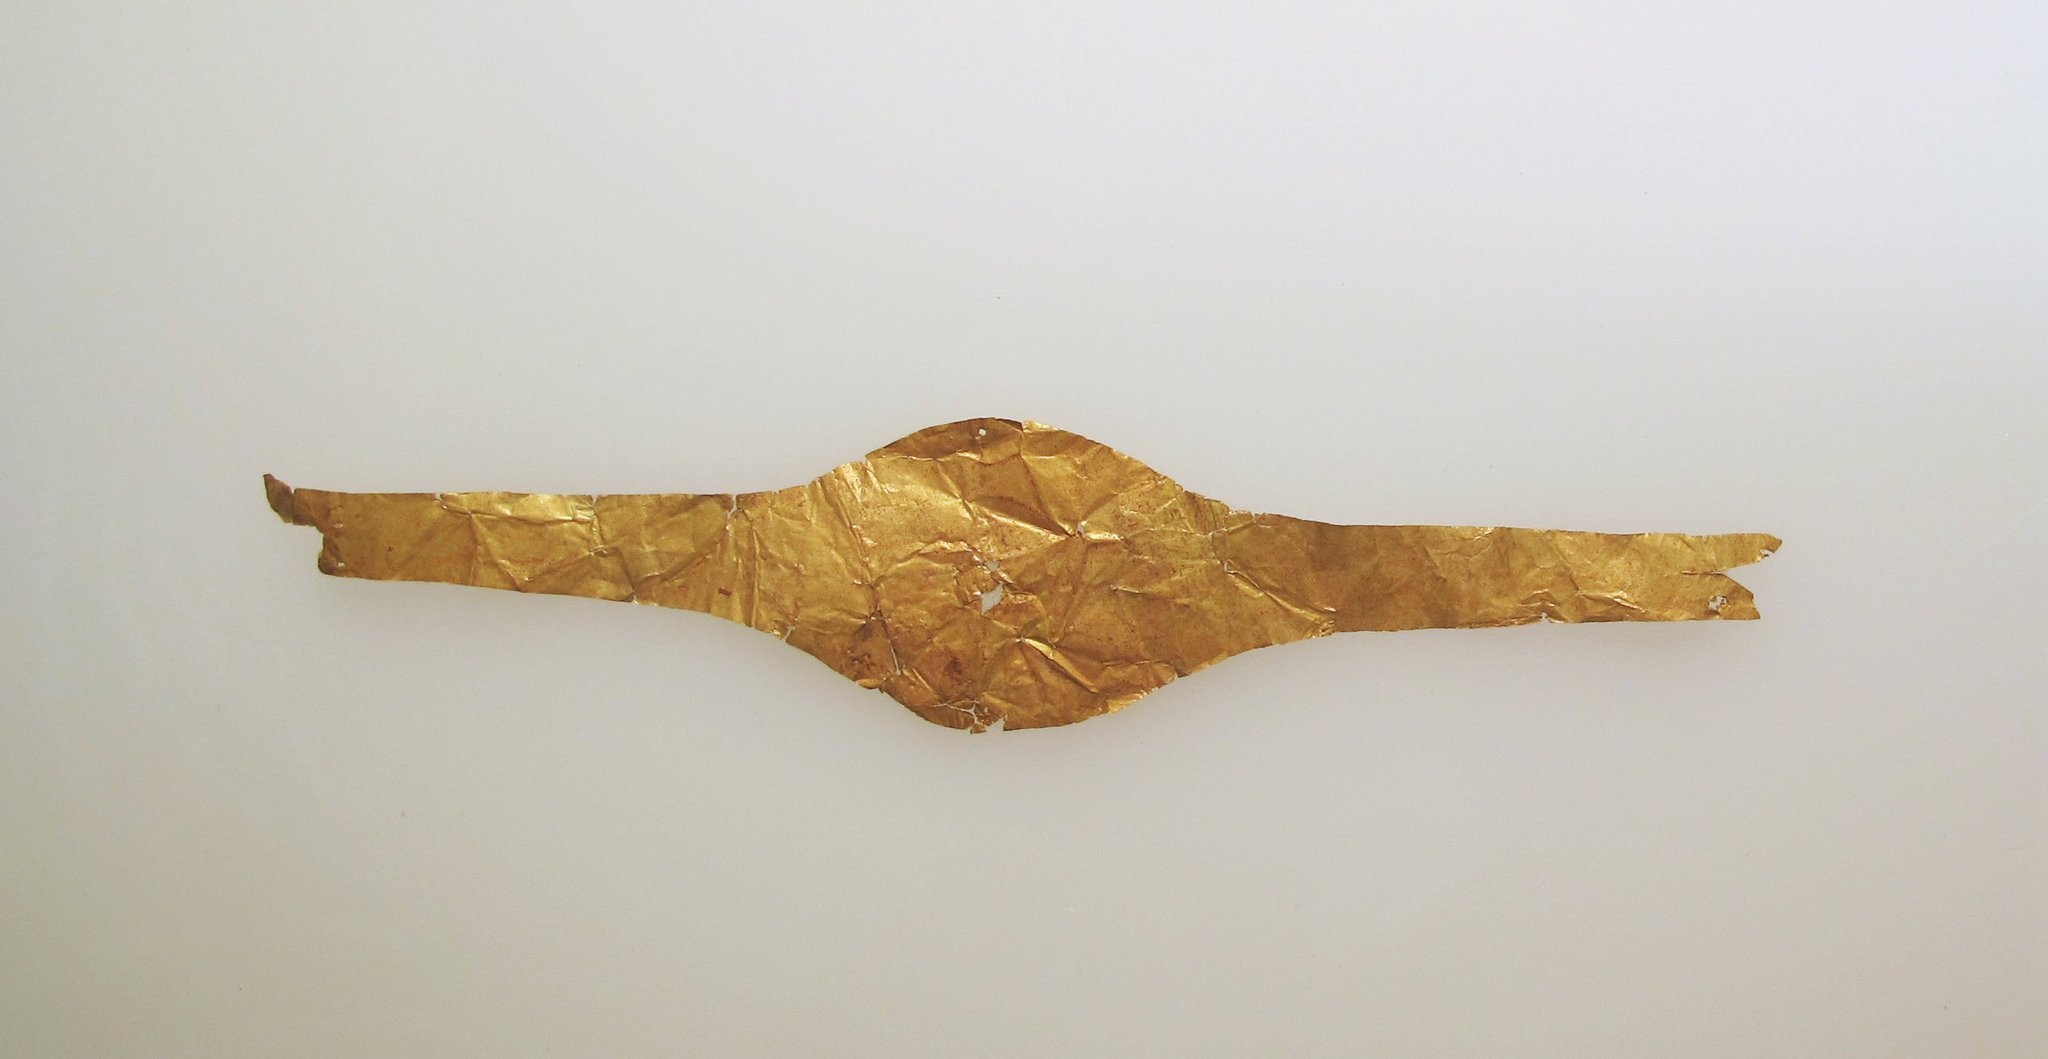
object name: frontlet of gold leaf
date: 7000 BCE-330 CE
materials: gold